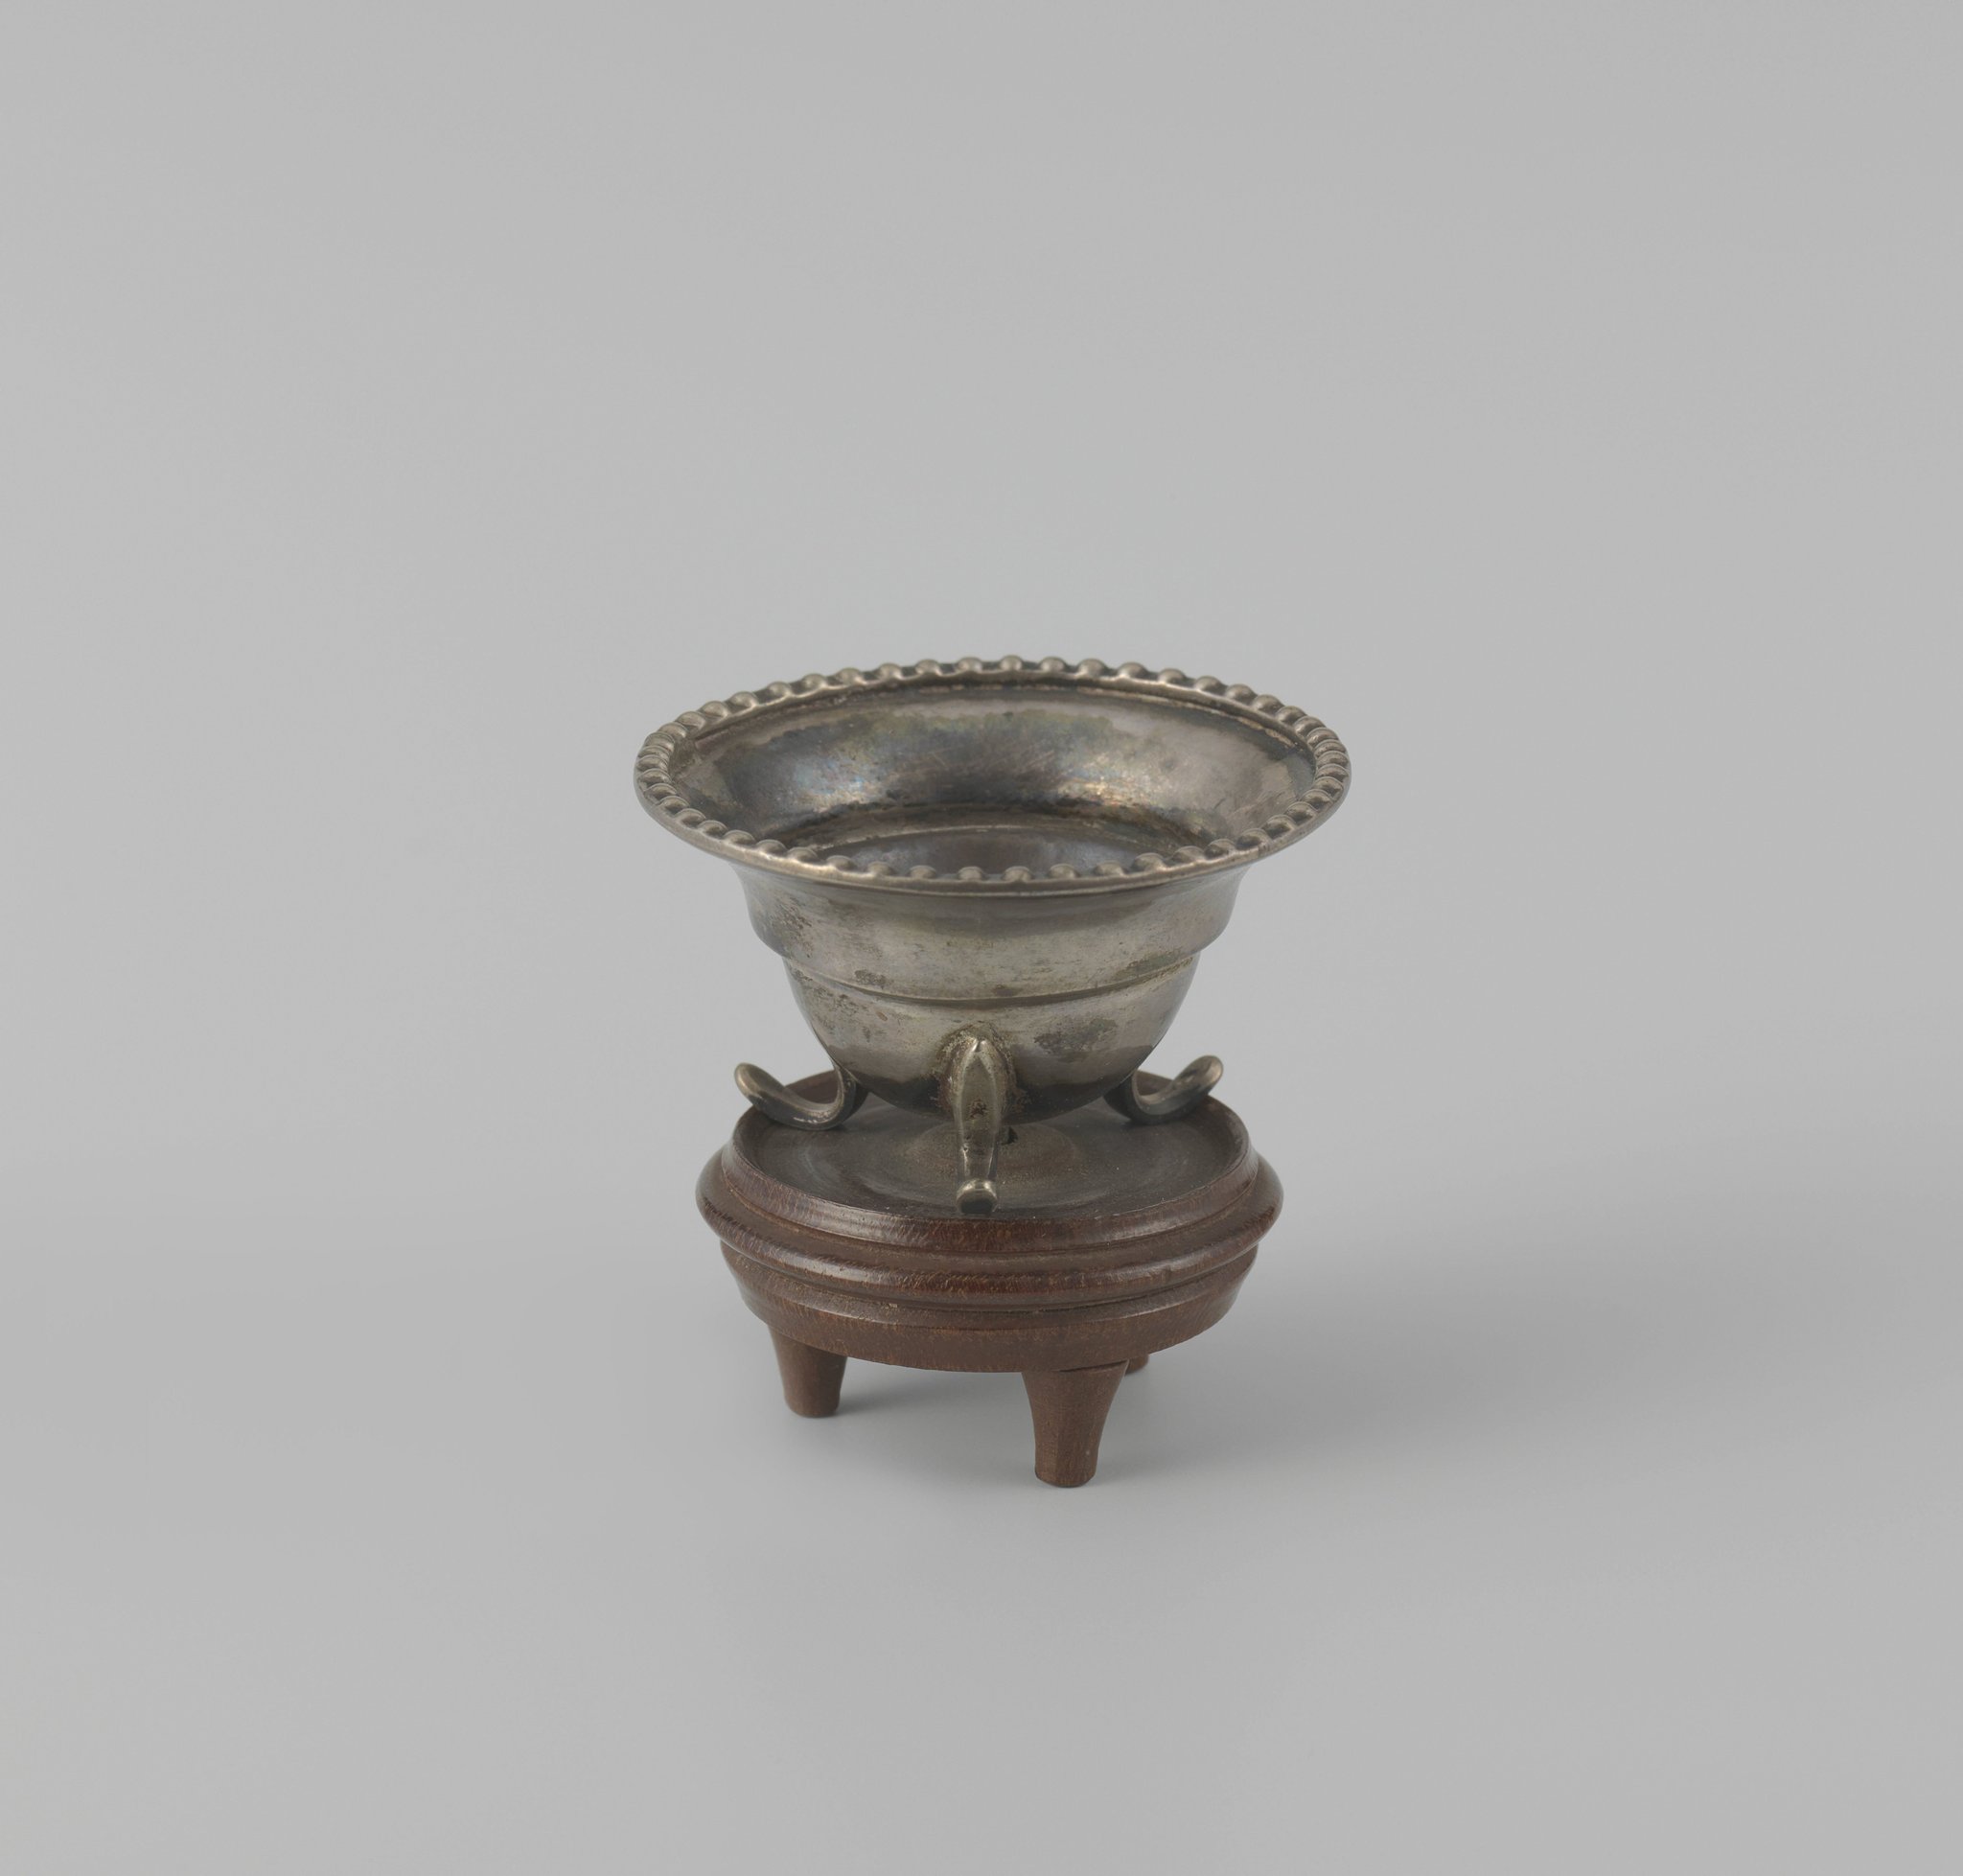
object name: miniature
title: Tabakskomfoor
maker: Anonymous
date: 1780-1820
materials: copper, silver, wood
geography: netherlands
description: Tabakskomfoor op drie naar buiten gebogen poten die op een houten voetstuk zijn bevestigd. Het houten voetstuk staat op drie rechte poten. In het komfoor zit een koperen binnenbak. Het tabakskomfoor is niet gemerkt.